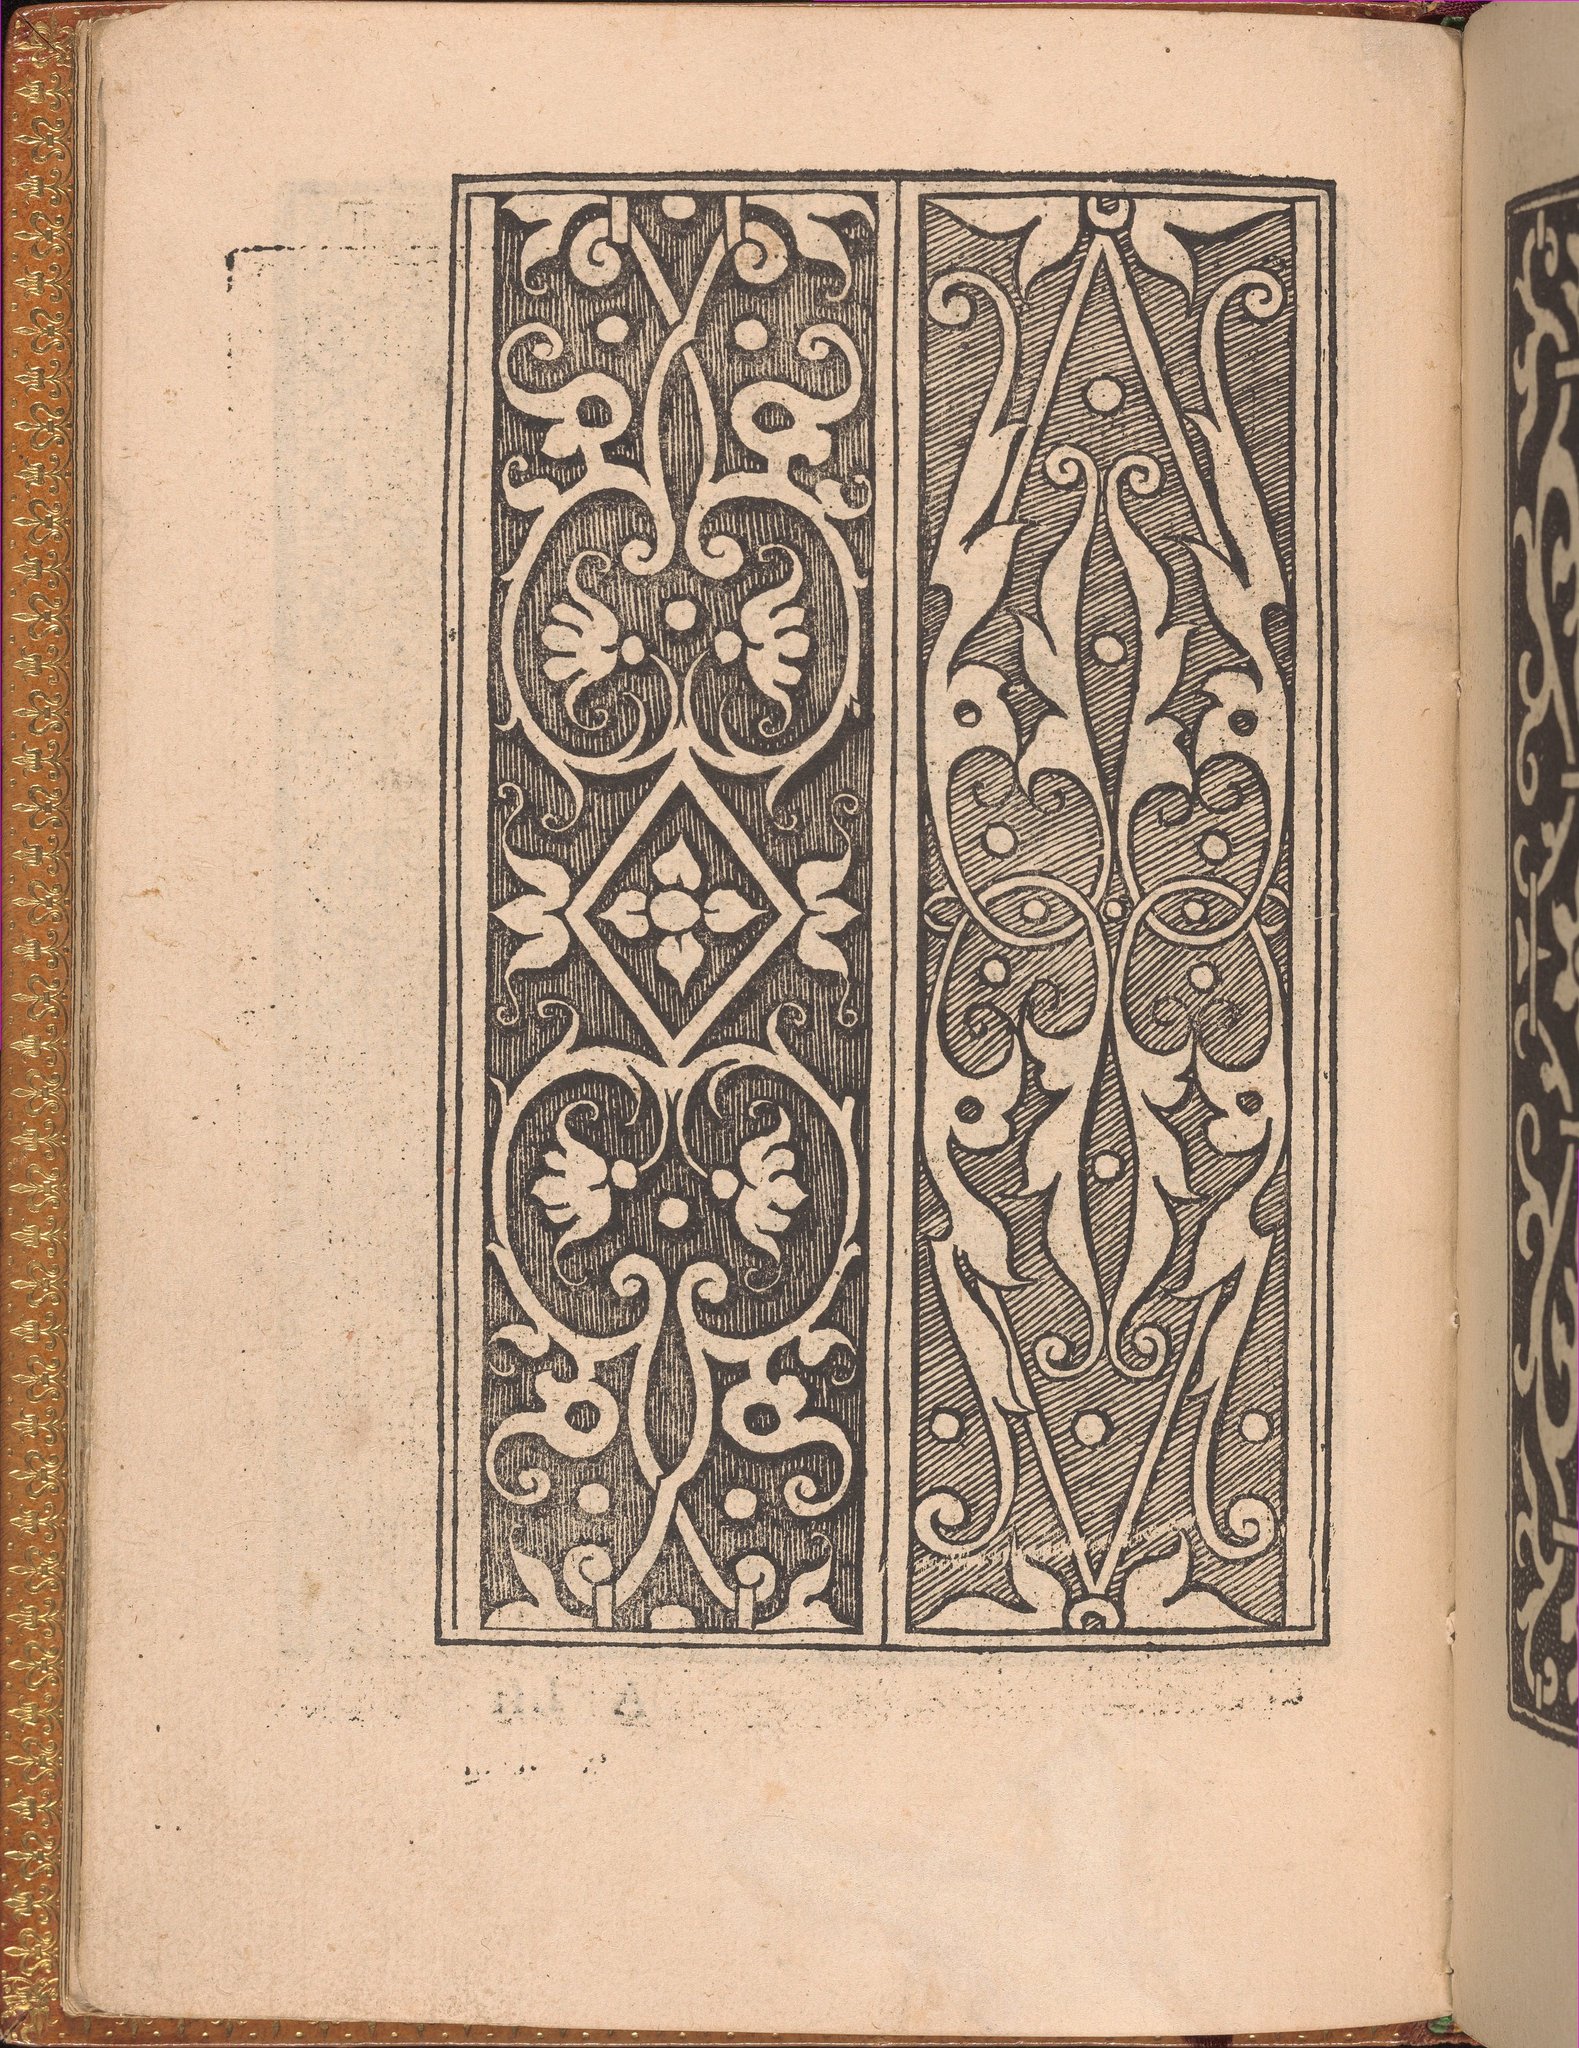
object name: book print ornament architecture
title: Convivio delle Belle Donne, page 4 (verso)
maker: nicolò zoppino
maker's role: publisher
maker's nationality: italian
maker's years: 1478-1544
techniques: woodcut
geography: italy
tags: ornament